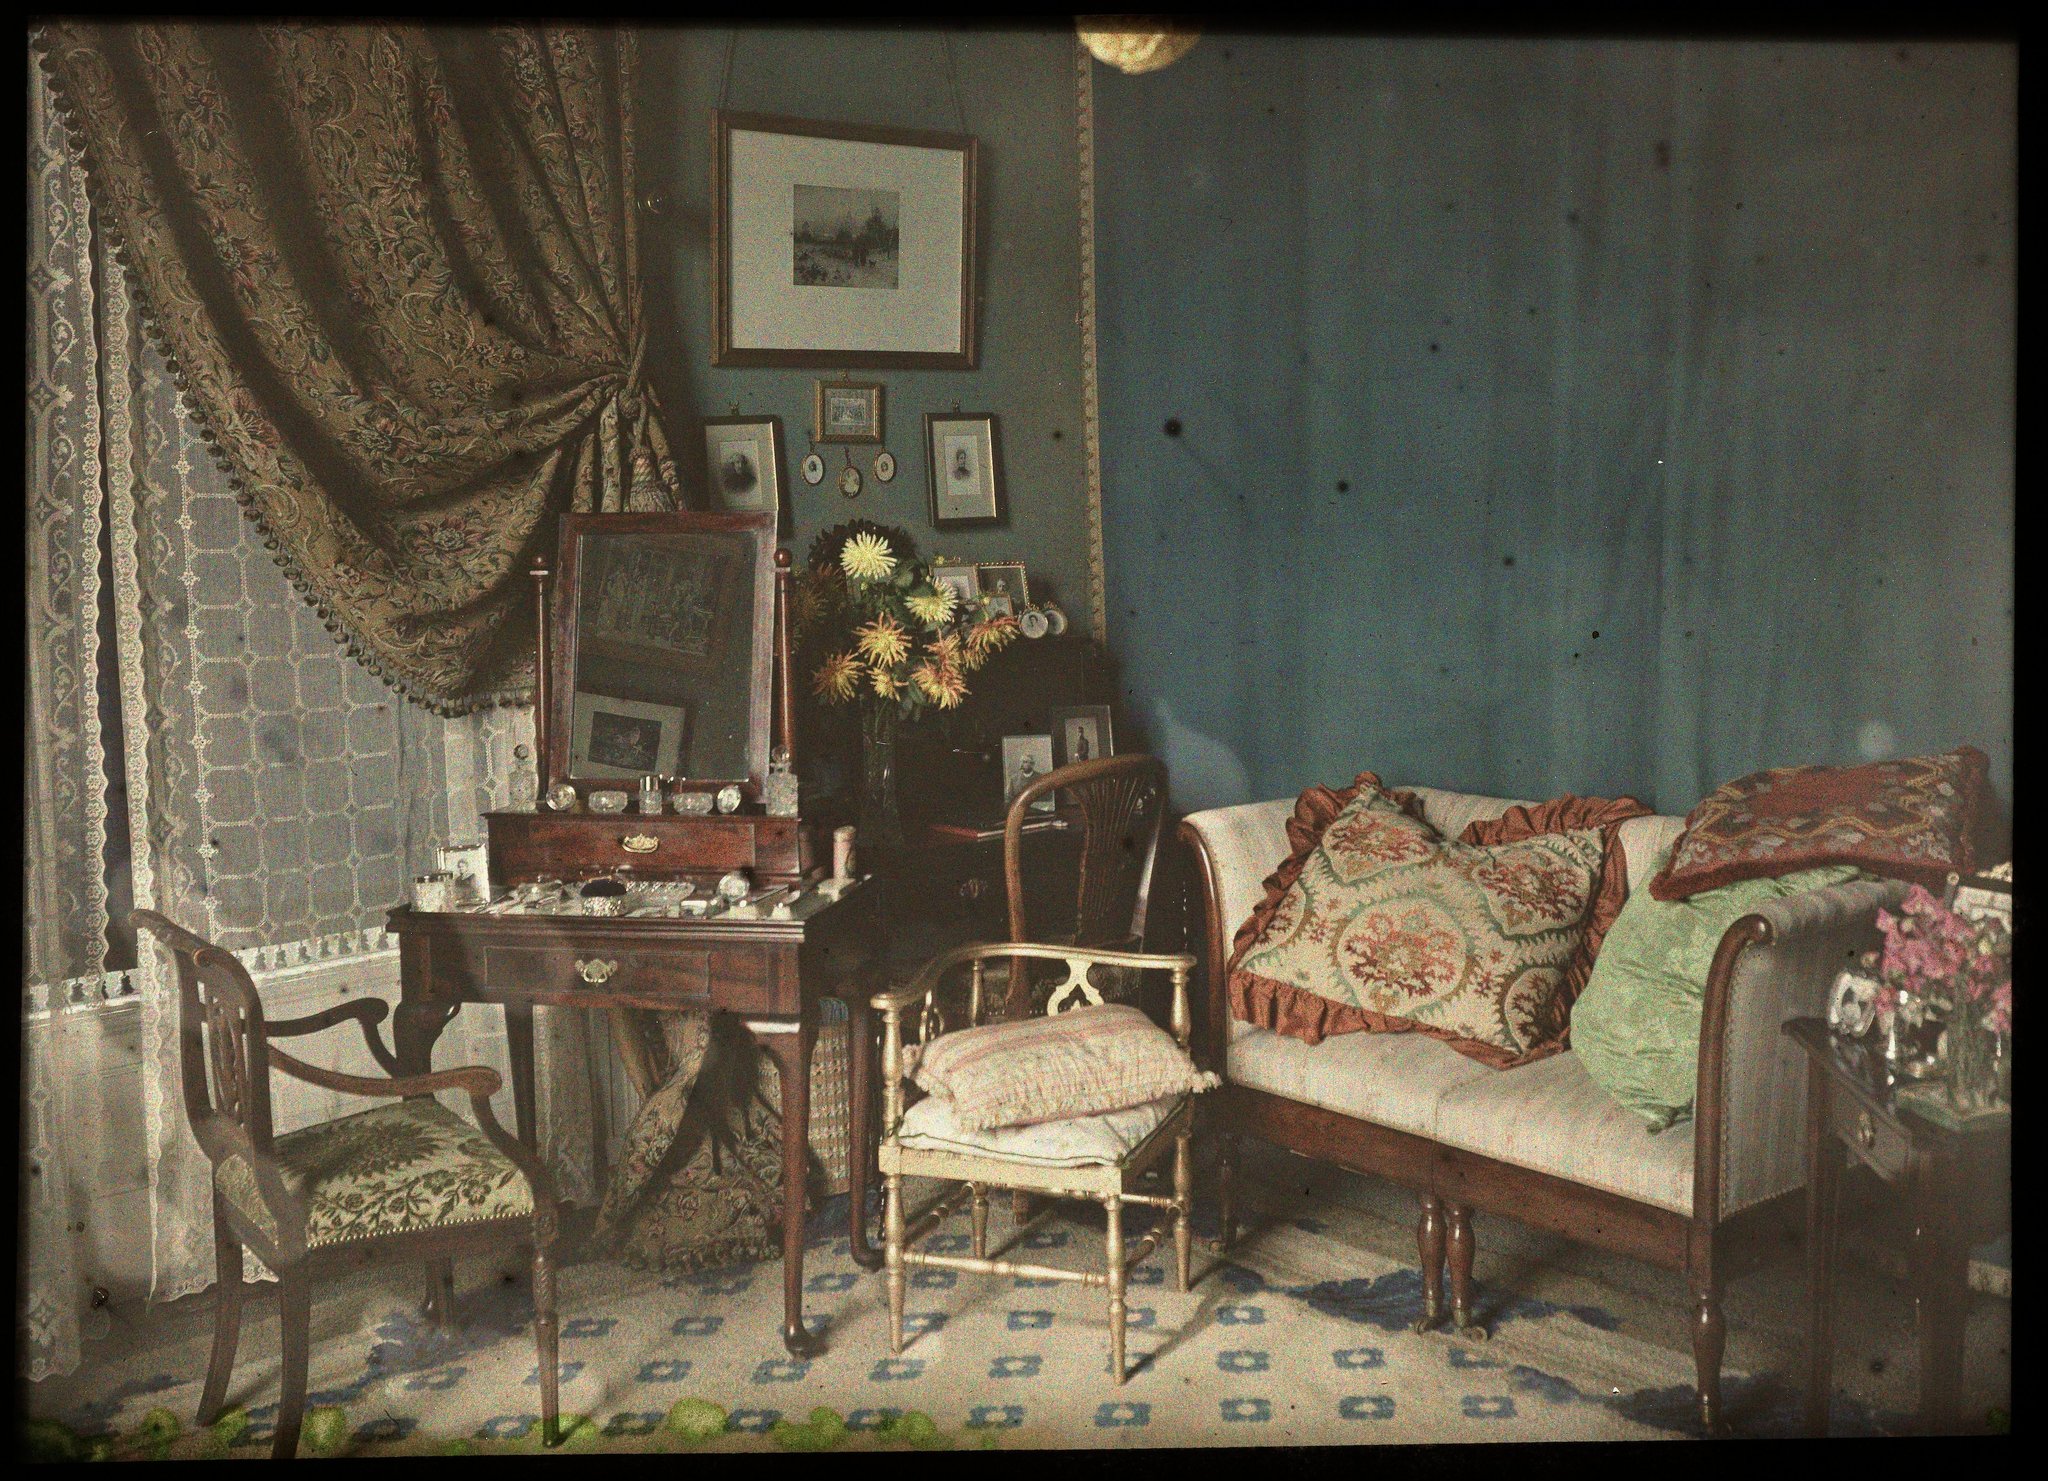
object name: photograph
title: Vrouwenkamer met toilettafel en sofa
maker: Anonymous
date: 1915-1925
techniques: autochrome process, slide